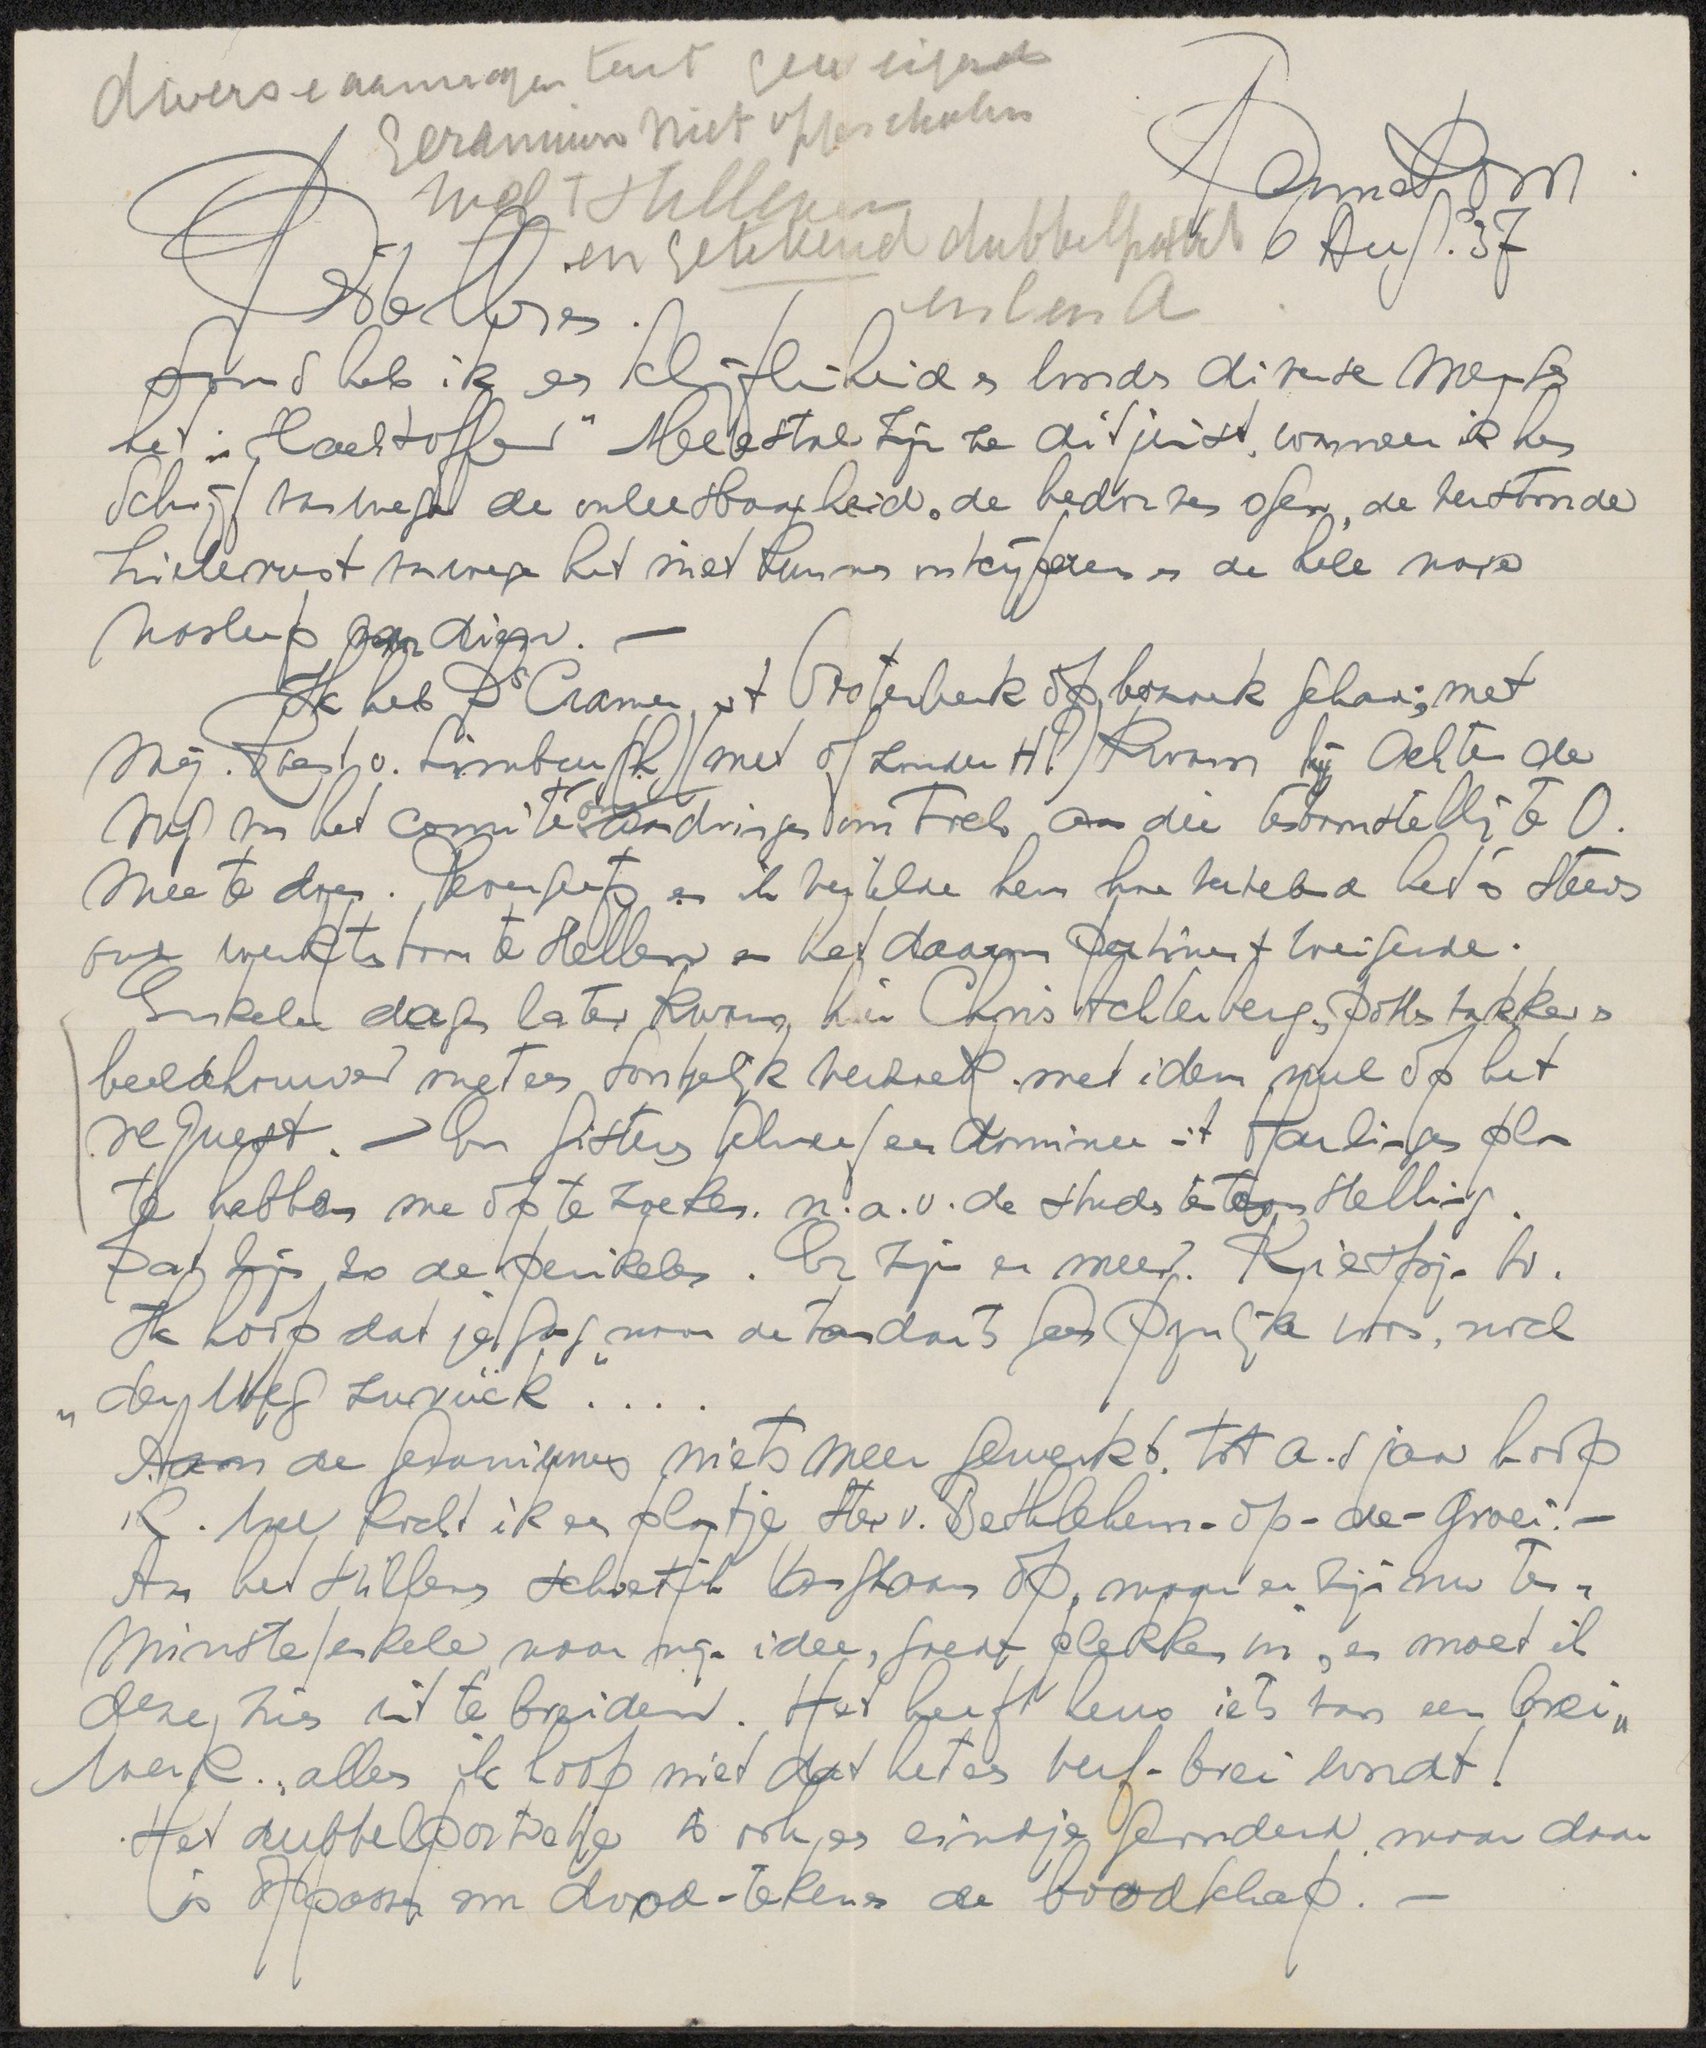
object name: letter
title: Brief aan Mien Cambier van Nooten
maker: dick ket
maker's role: draughtsman, print maker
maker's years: 1902-1940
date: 1937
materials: ink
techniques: pen, writing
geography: bennekom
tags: amsterdam, utrecht, print maker, chris agterberg, arnhem, mien cambier van nooten, painter, painting (including book-illumination, miniature-painting), exhibition ~ art, historical persons (portraits and scenes from the life)